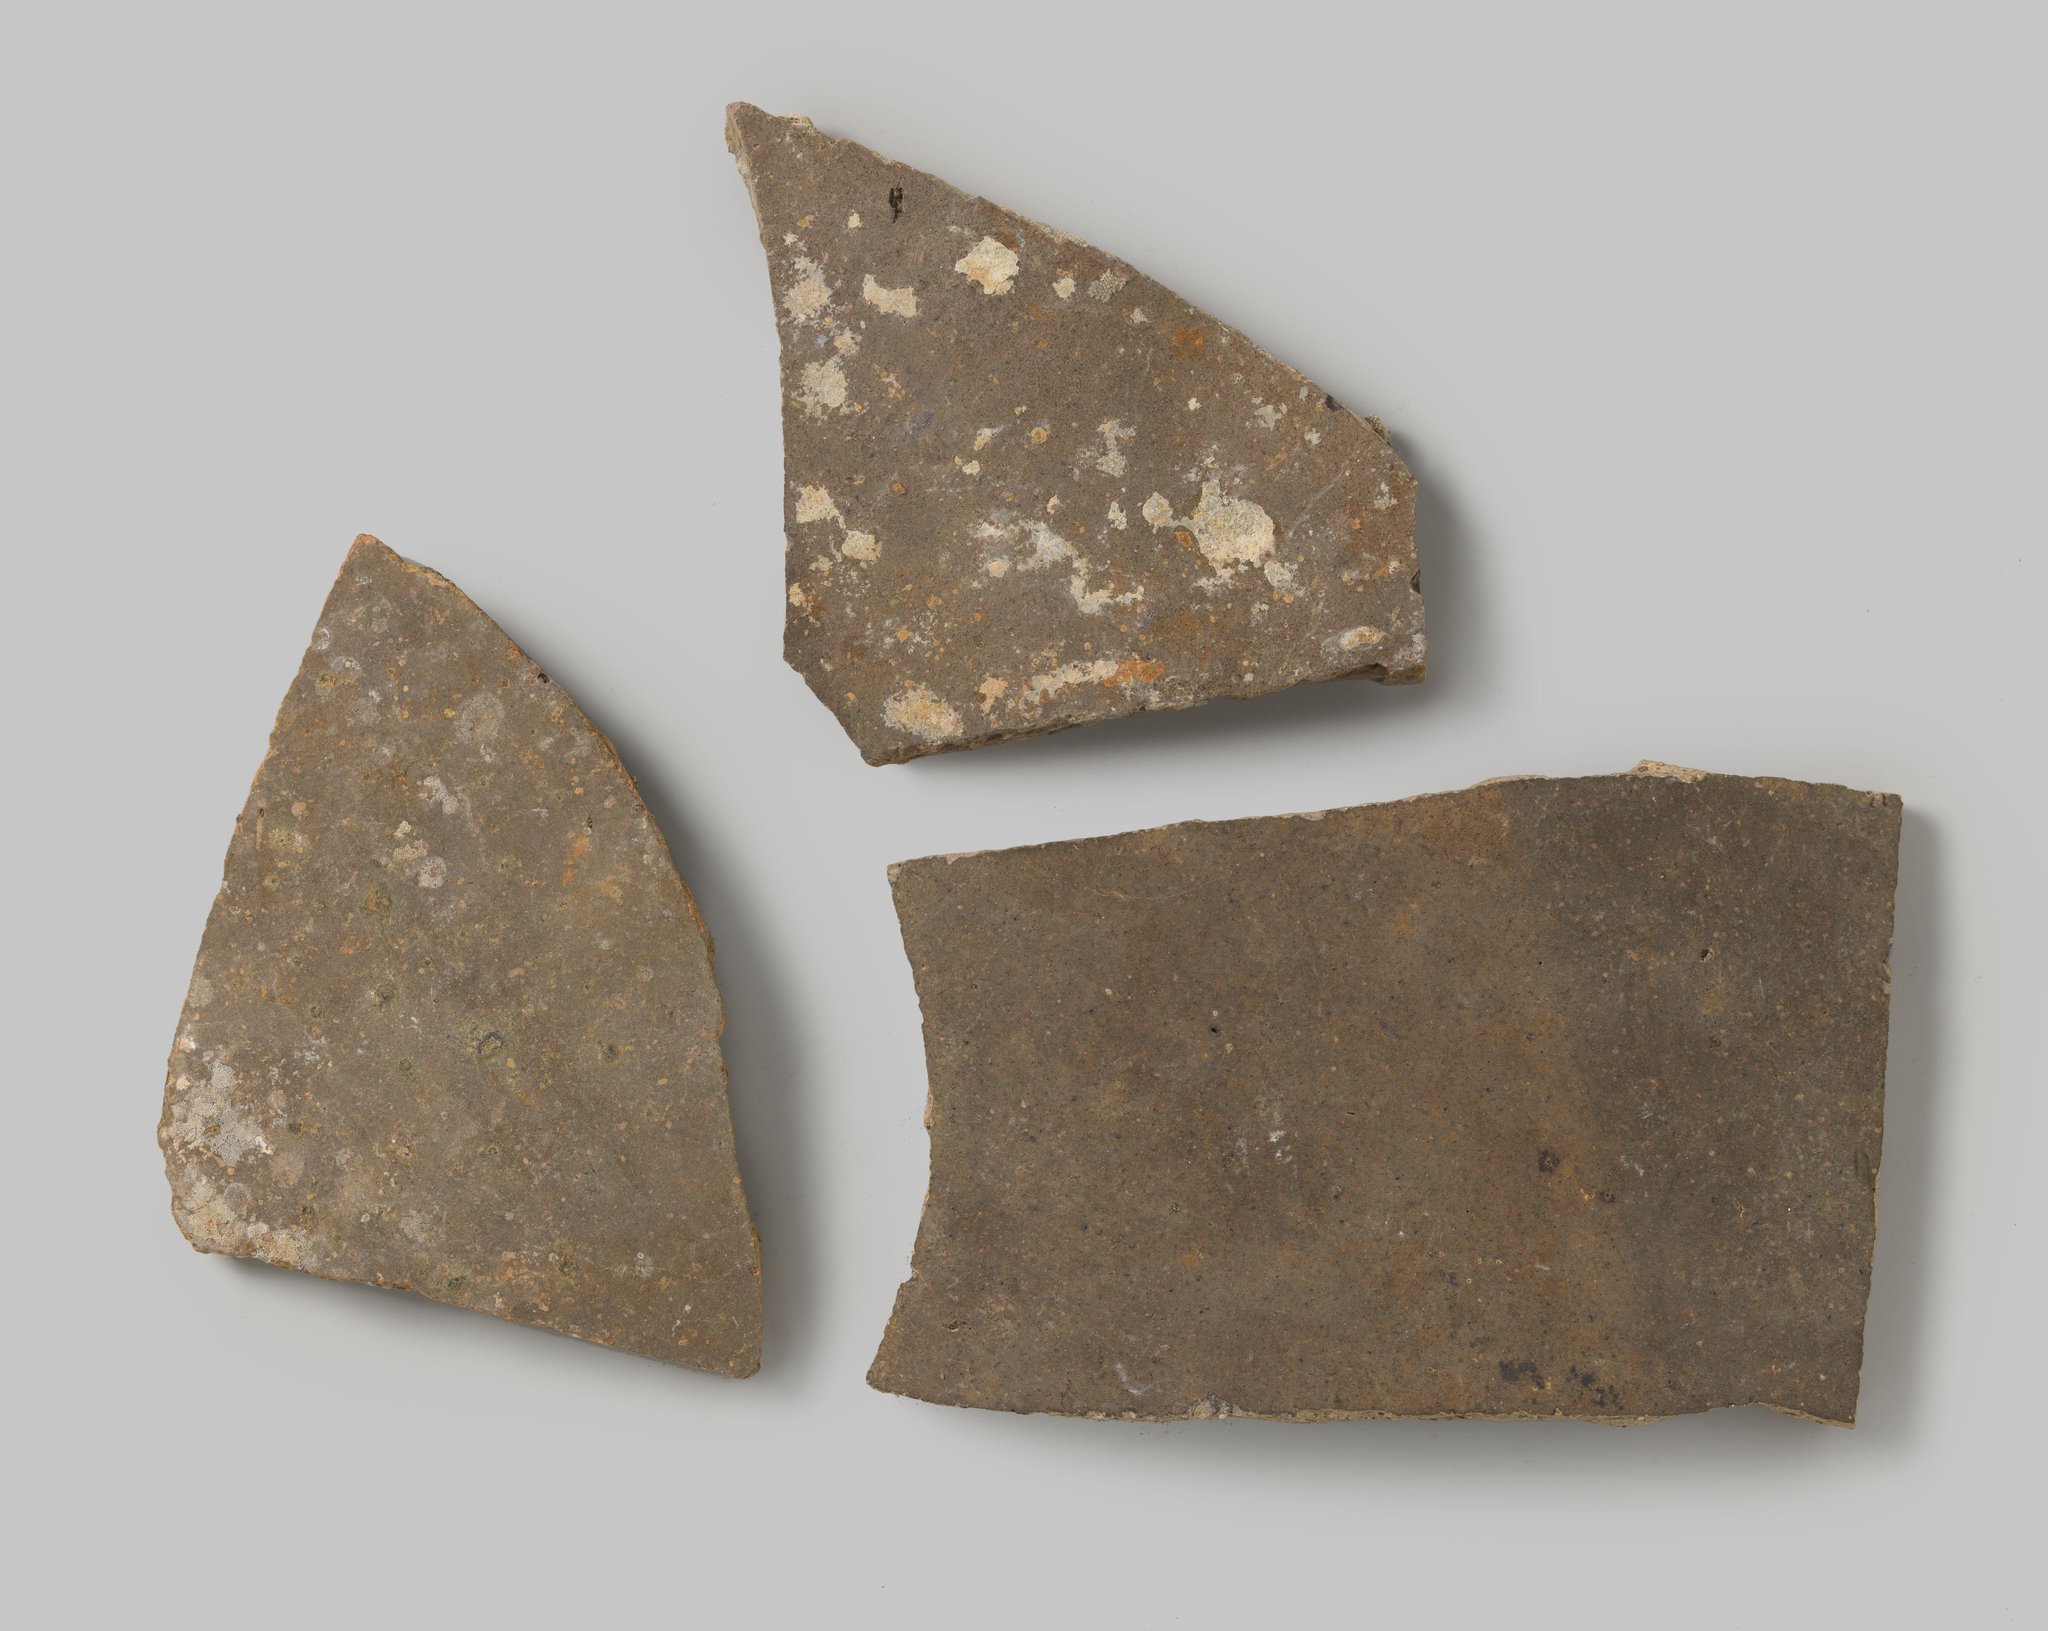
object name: sherd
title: Scherven van martavanen uit het wrak van de Oostindiëvaarder Hollandia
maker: Anonymous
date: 1700-1743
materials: porcelain, stoneware